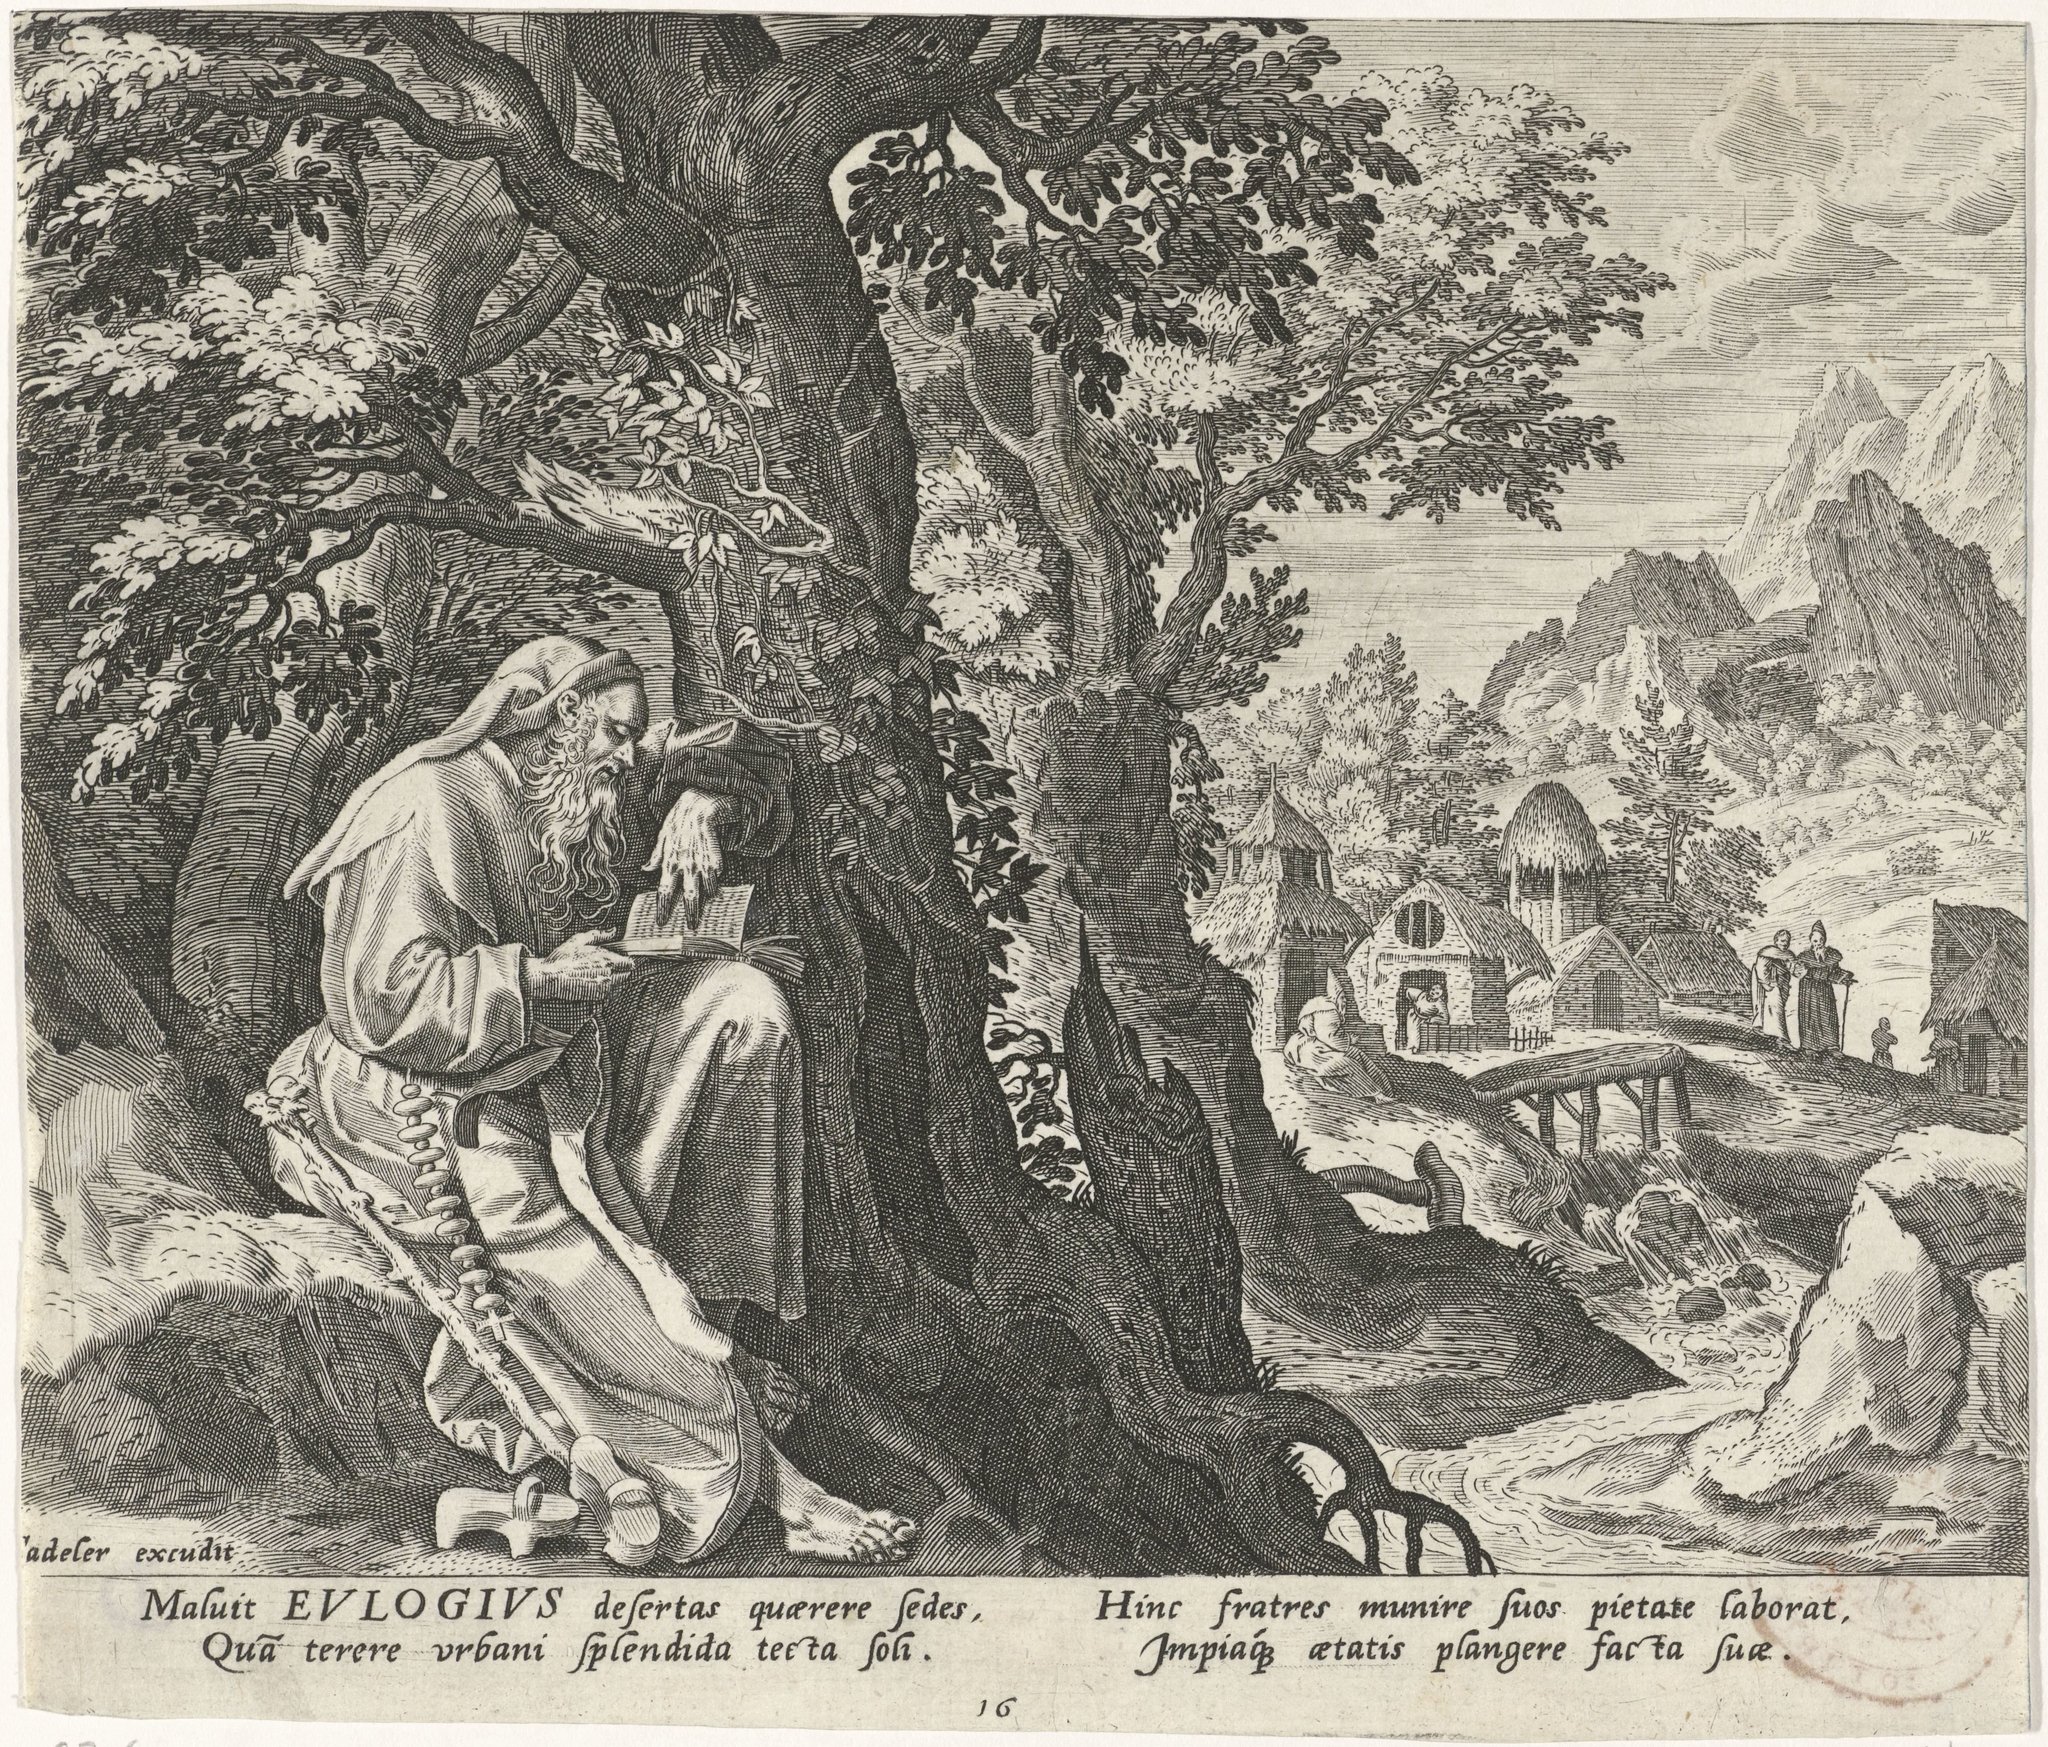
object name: print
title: Solitudo Sive Vitae Patrum Eremicolarum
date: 1583-1588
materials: paper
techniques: engraving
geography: antwerp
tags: saints, anchorite, hermit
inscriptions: collector's mark: Lugt 240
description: Eulogius de kluizenaar in de wildernis. Hij leest een bijbel. Een landschap met een dorp met kluizenaars op de achtergrond.